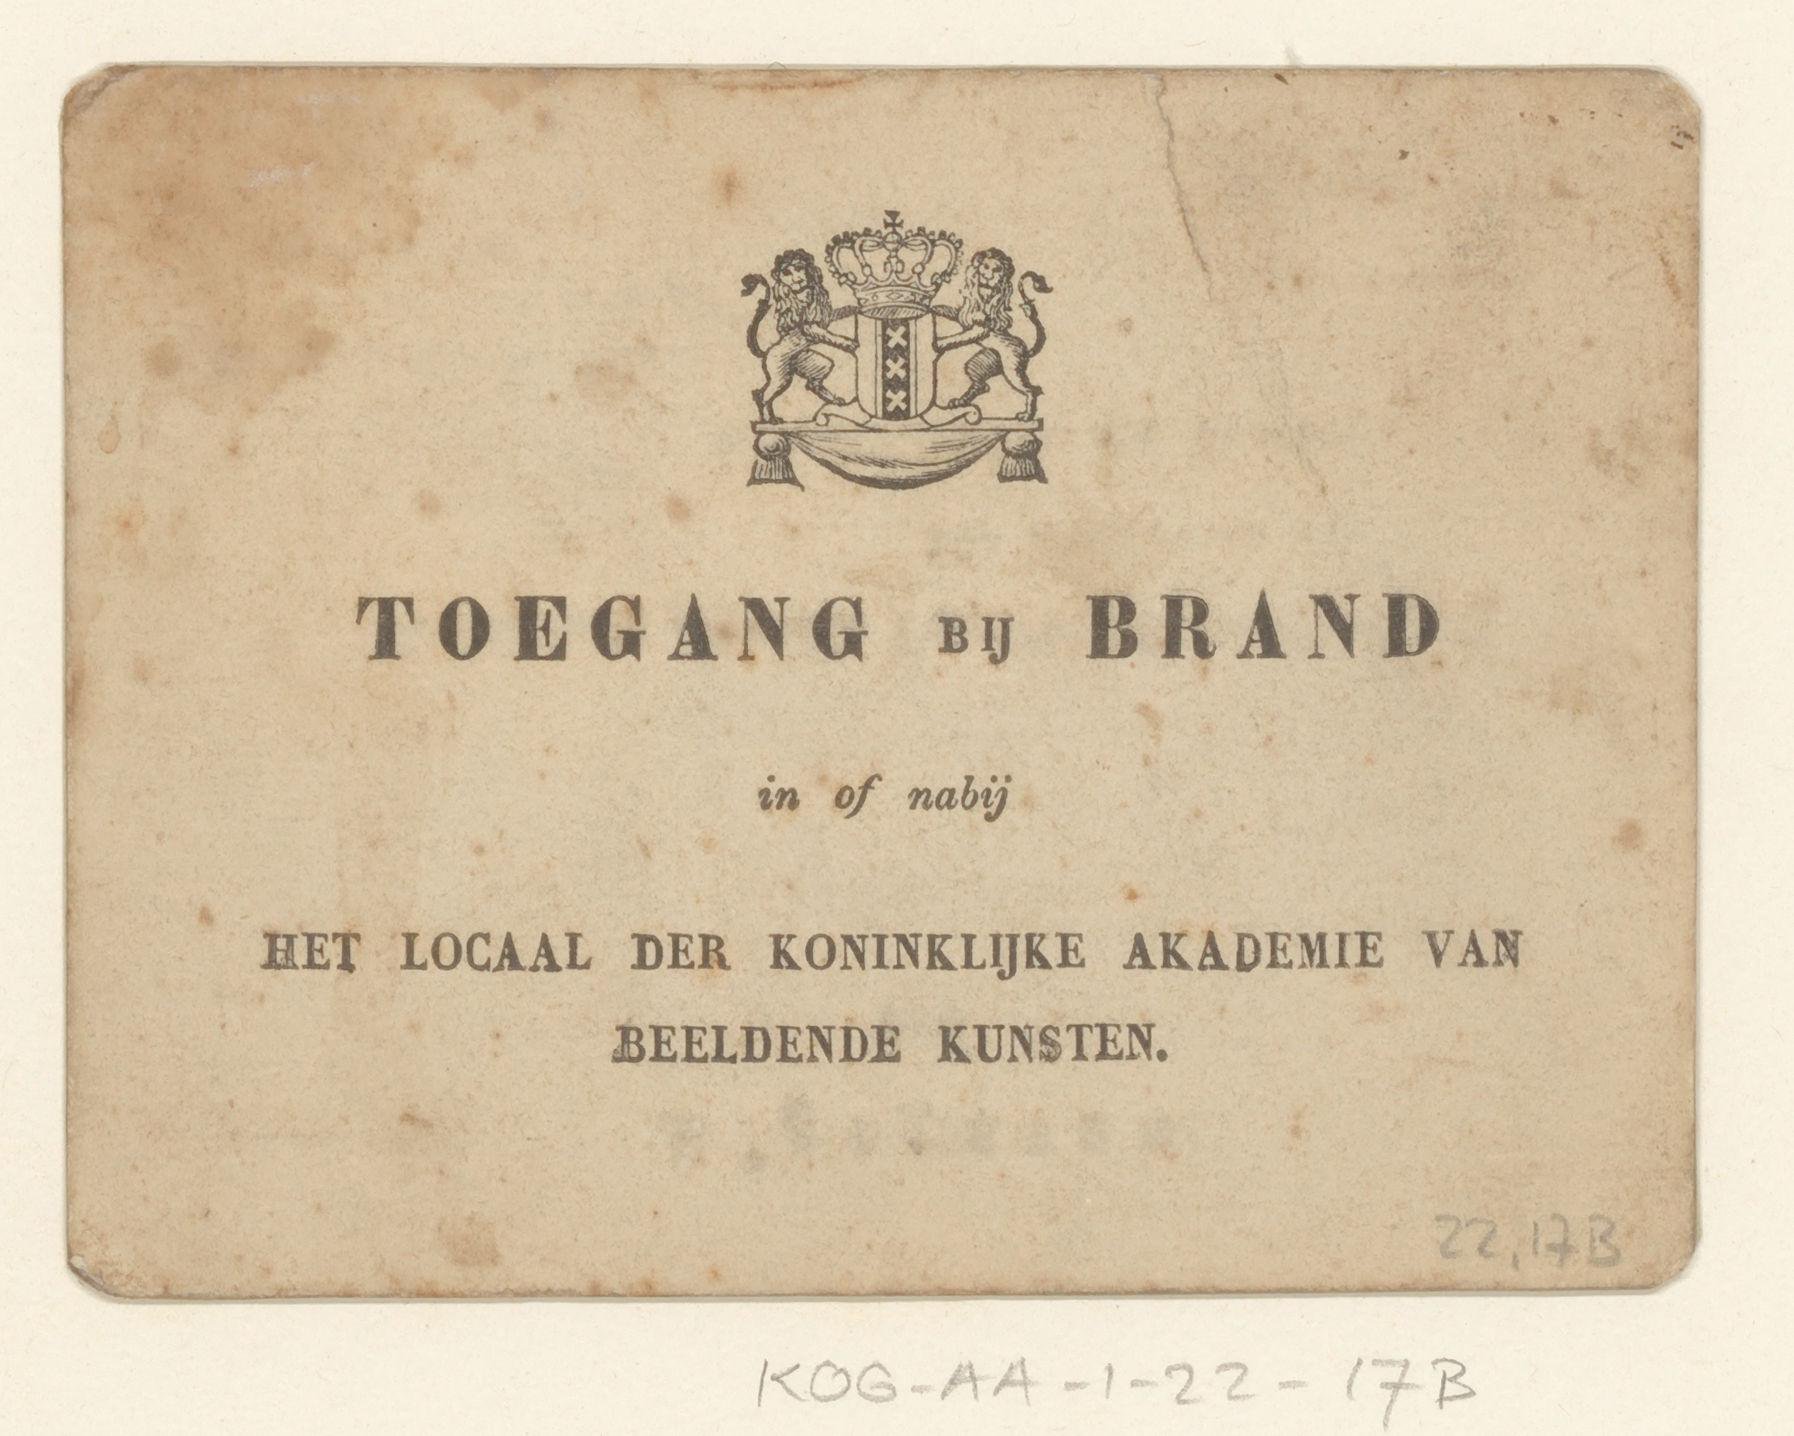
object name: text sheet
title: Toegangsbewijs bij brand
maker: Anonymous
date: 1820-1870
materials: cardboard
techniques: letterpress printing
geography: netherlands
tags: coat of arms (as symbol of the state, etc.) (+ city; municipal)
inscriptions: collector's mark: Lugt 1641b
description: Onderwerpsrubriek binnen de Atlas Amsterdam: Gemeentewerken: A. Brandweer.